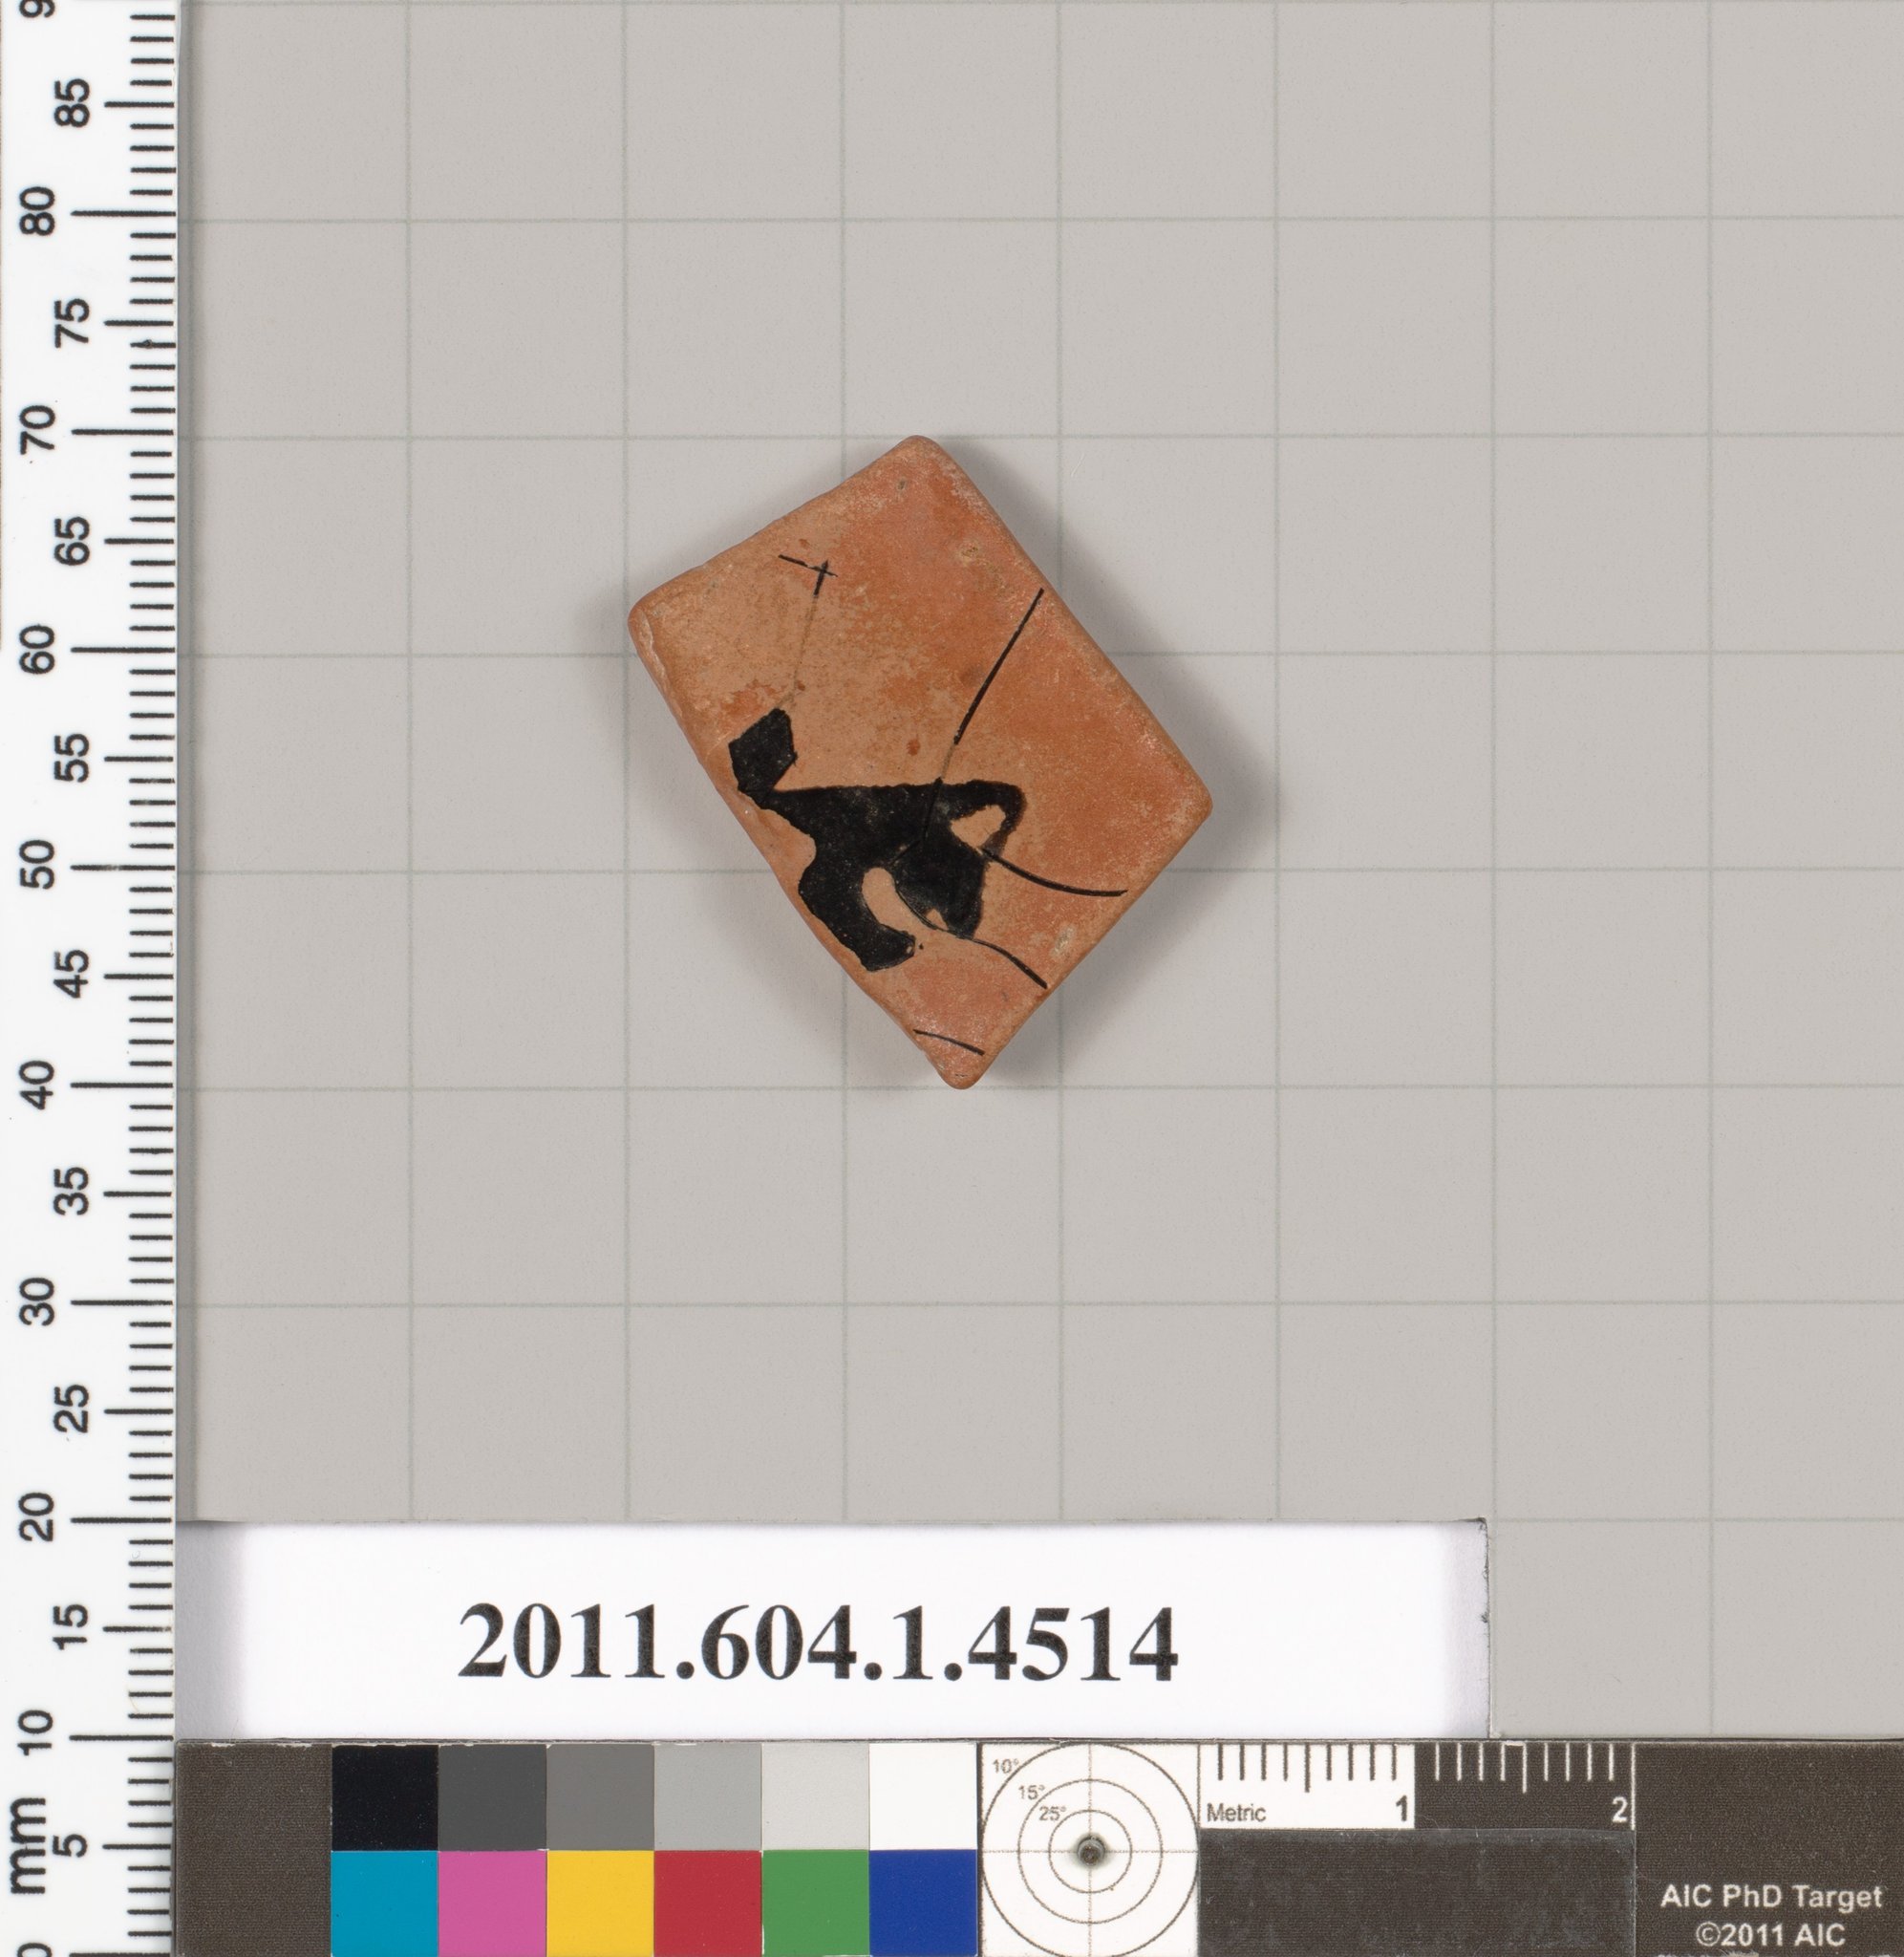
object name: kylix fragment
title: Terracotta fragment of a kylix (drinking cup)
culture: greek, attic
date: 490-470 BCE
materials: terracotta